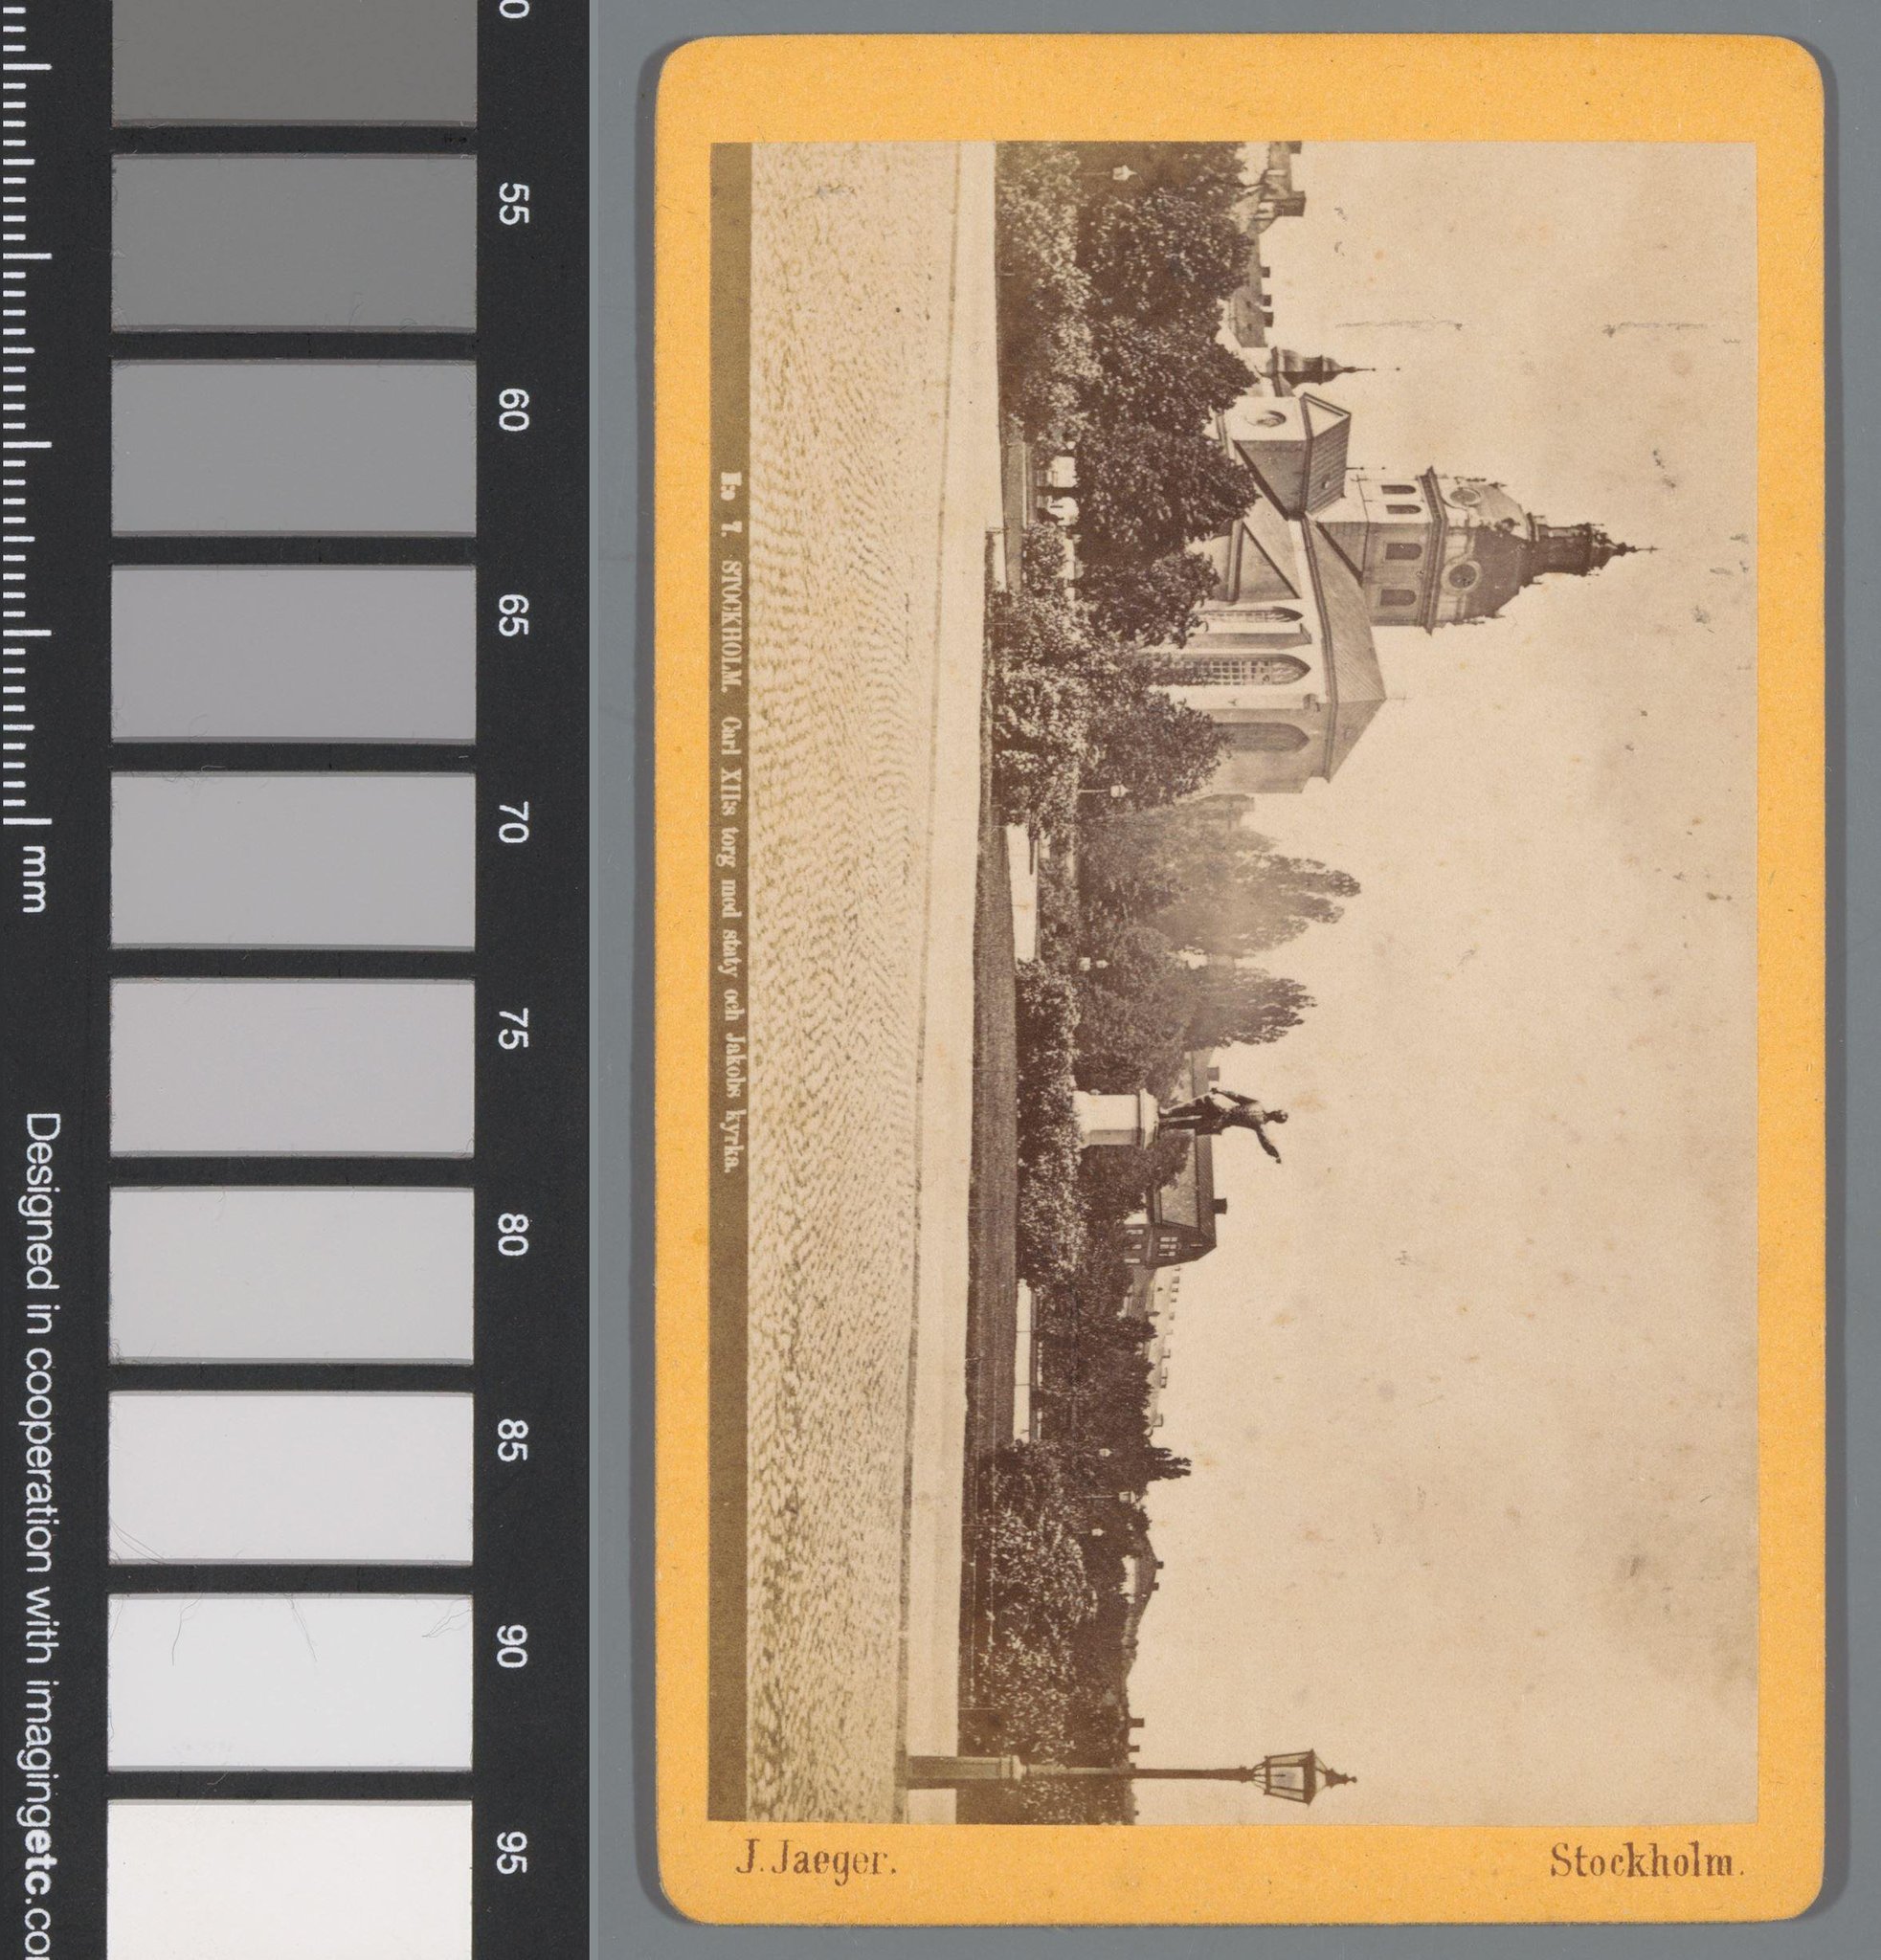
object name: photograph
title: Stockholm, Carl XII's torg med staty och Jakobs kyrka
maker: johannes jaeger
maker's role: fotograaf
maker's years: 1832-1908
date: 1865-1890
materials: cardboard, paper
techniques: albumen print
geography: stockholm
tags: square, place, circus, etc., church (exterior)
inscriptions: inscription: ‘N:o 7.’, inscription: ‘J. Jaeger. Stockholm.’, inscription: ‘Johannes Jaeger/ Kongl: Hof-fotograf./ Stockholm/ Drottninggatan No 5./ Körnet af Fredsgatan/ Originalplaten förvaras för vidare beställning.’